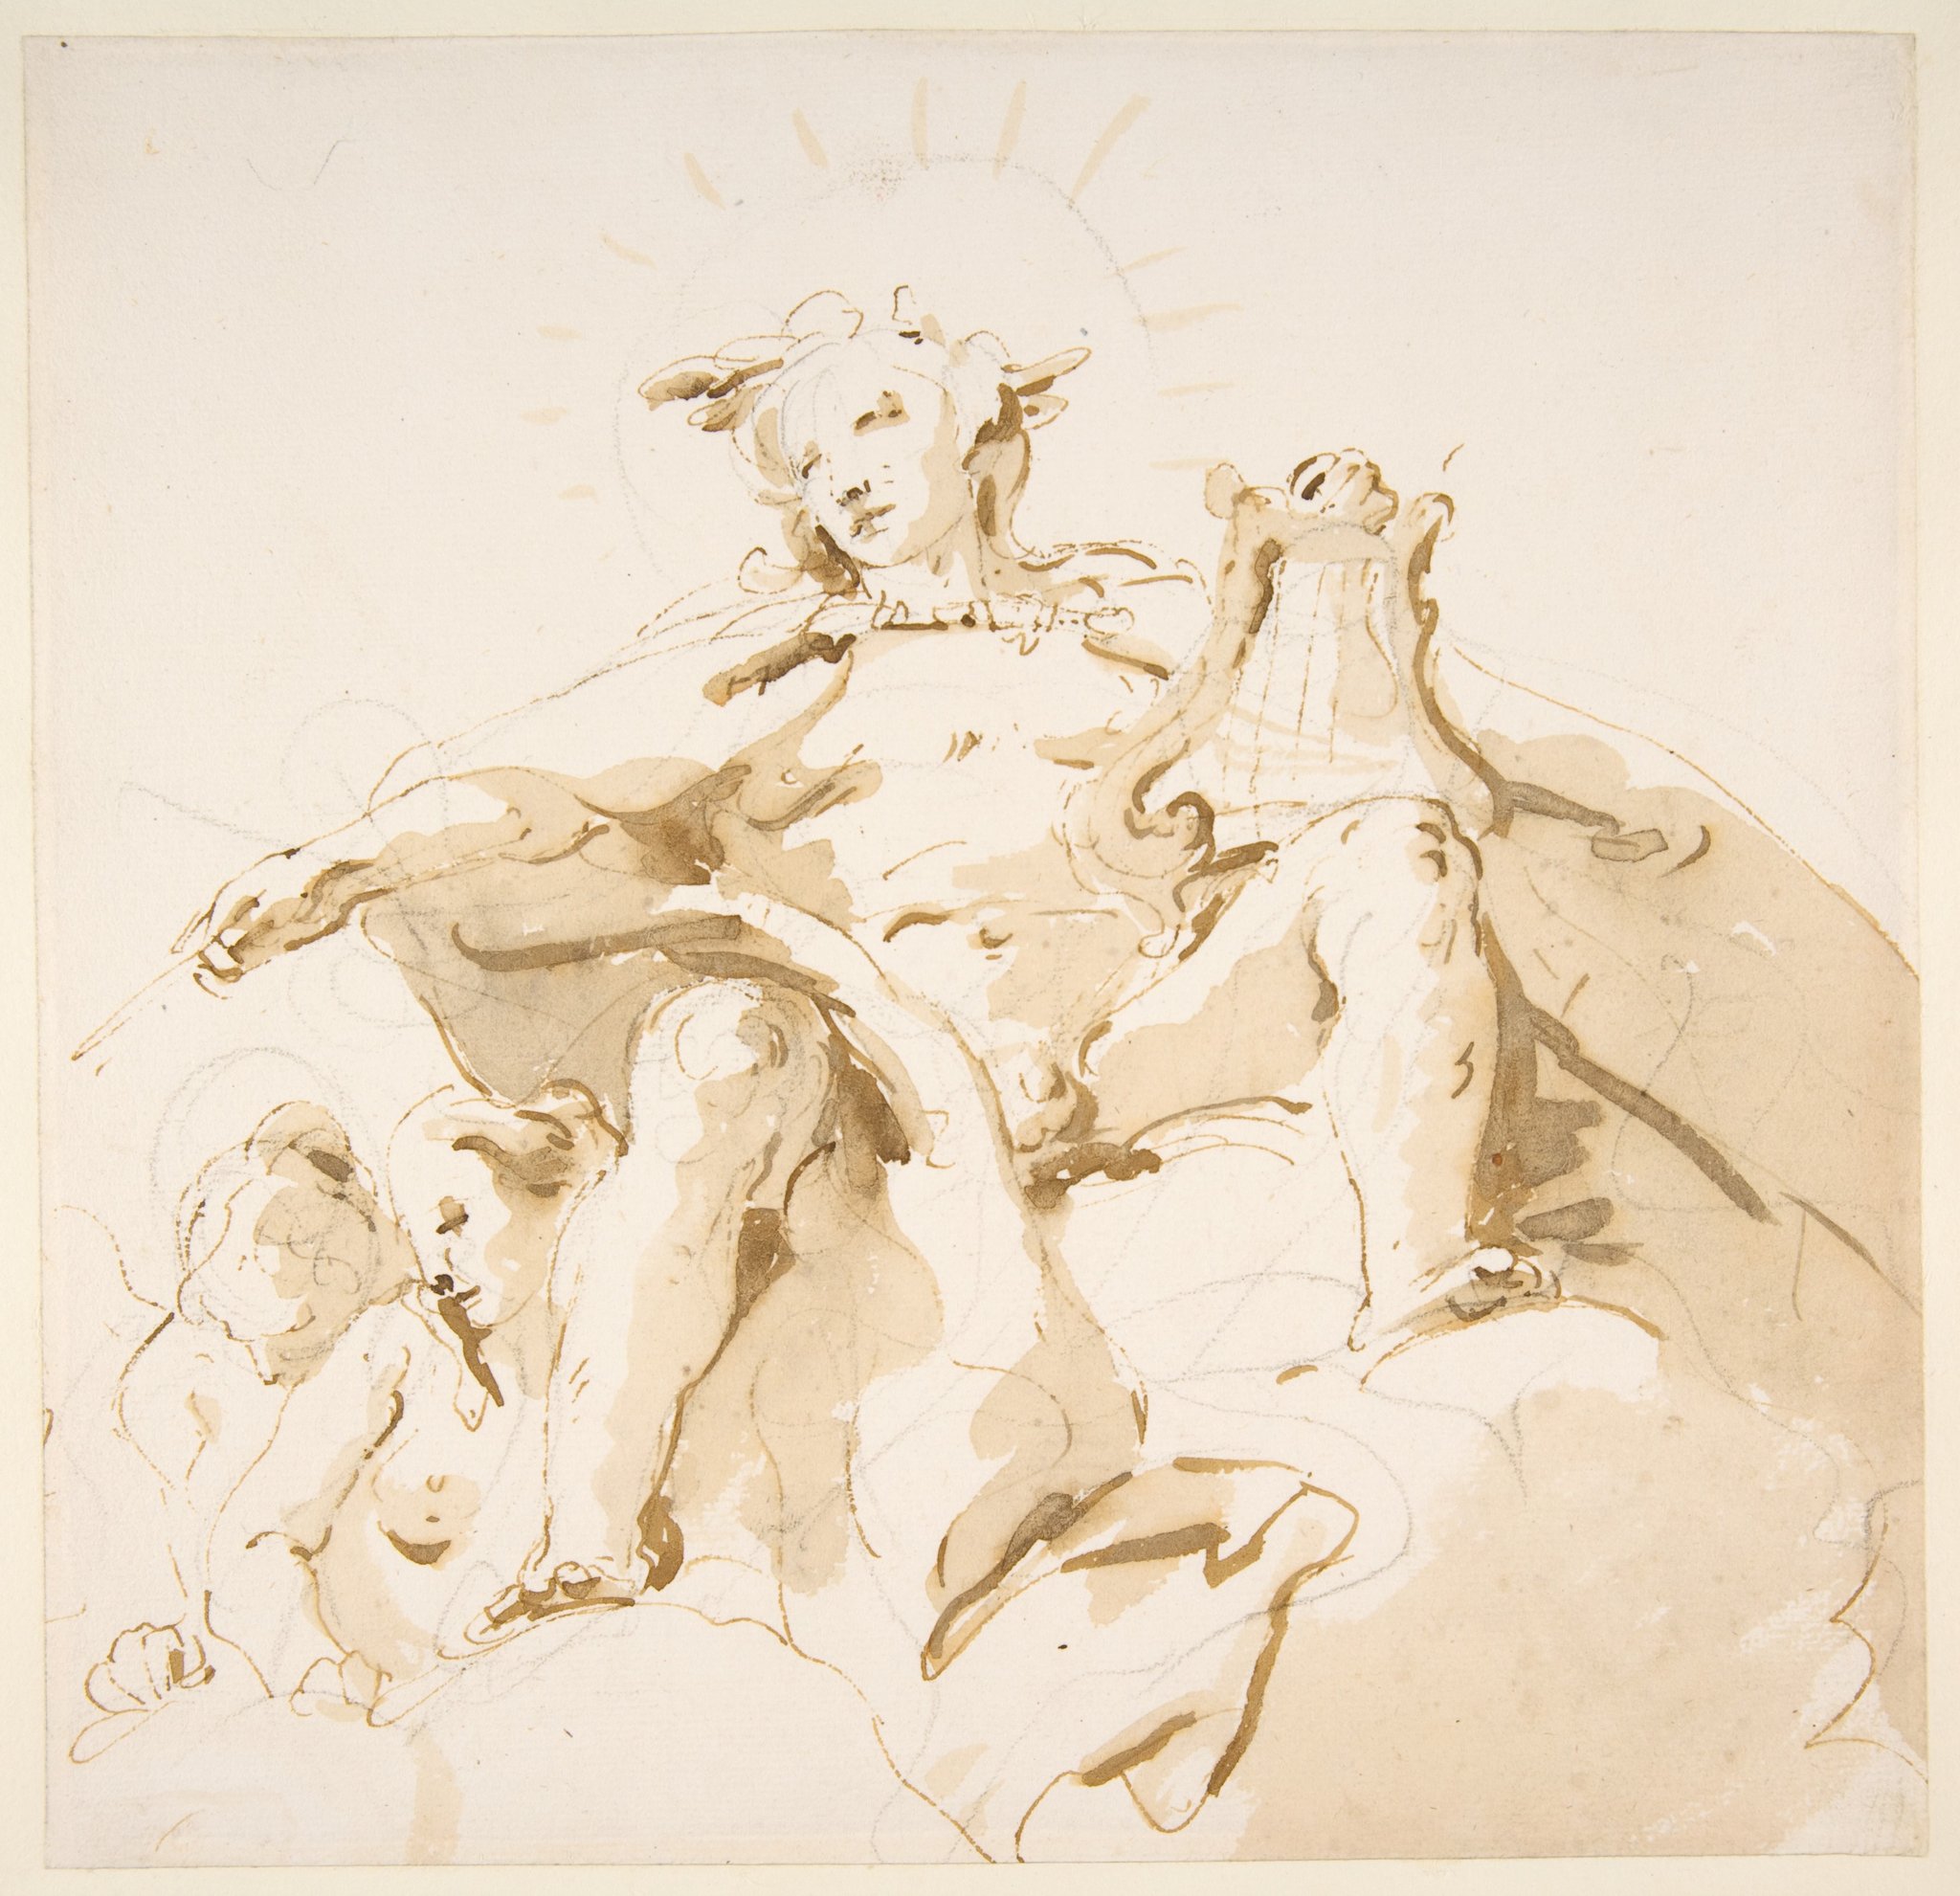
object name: drawing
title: Apollo Seated on Clouds, Two Figures at Left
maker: giovanni battista tiepolo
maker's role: artist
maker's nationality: italian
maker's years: 1696-1770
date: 1696-1770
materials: chalk, ink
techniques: brush, pen, wash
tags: male nudes,apollo,lyres